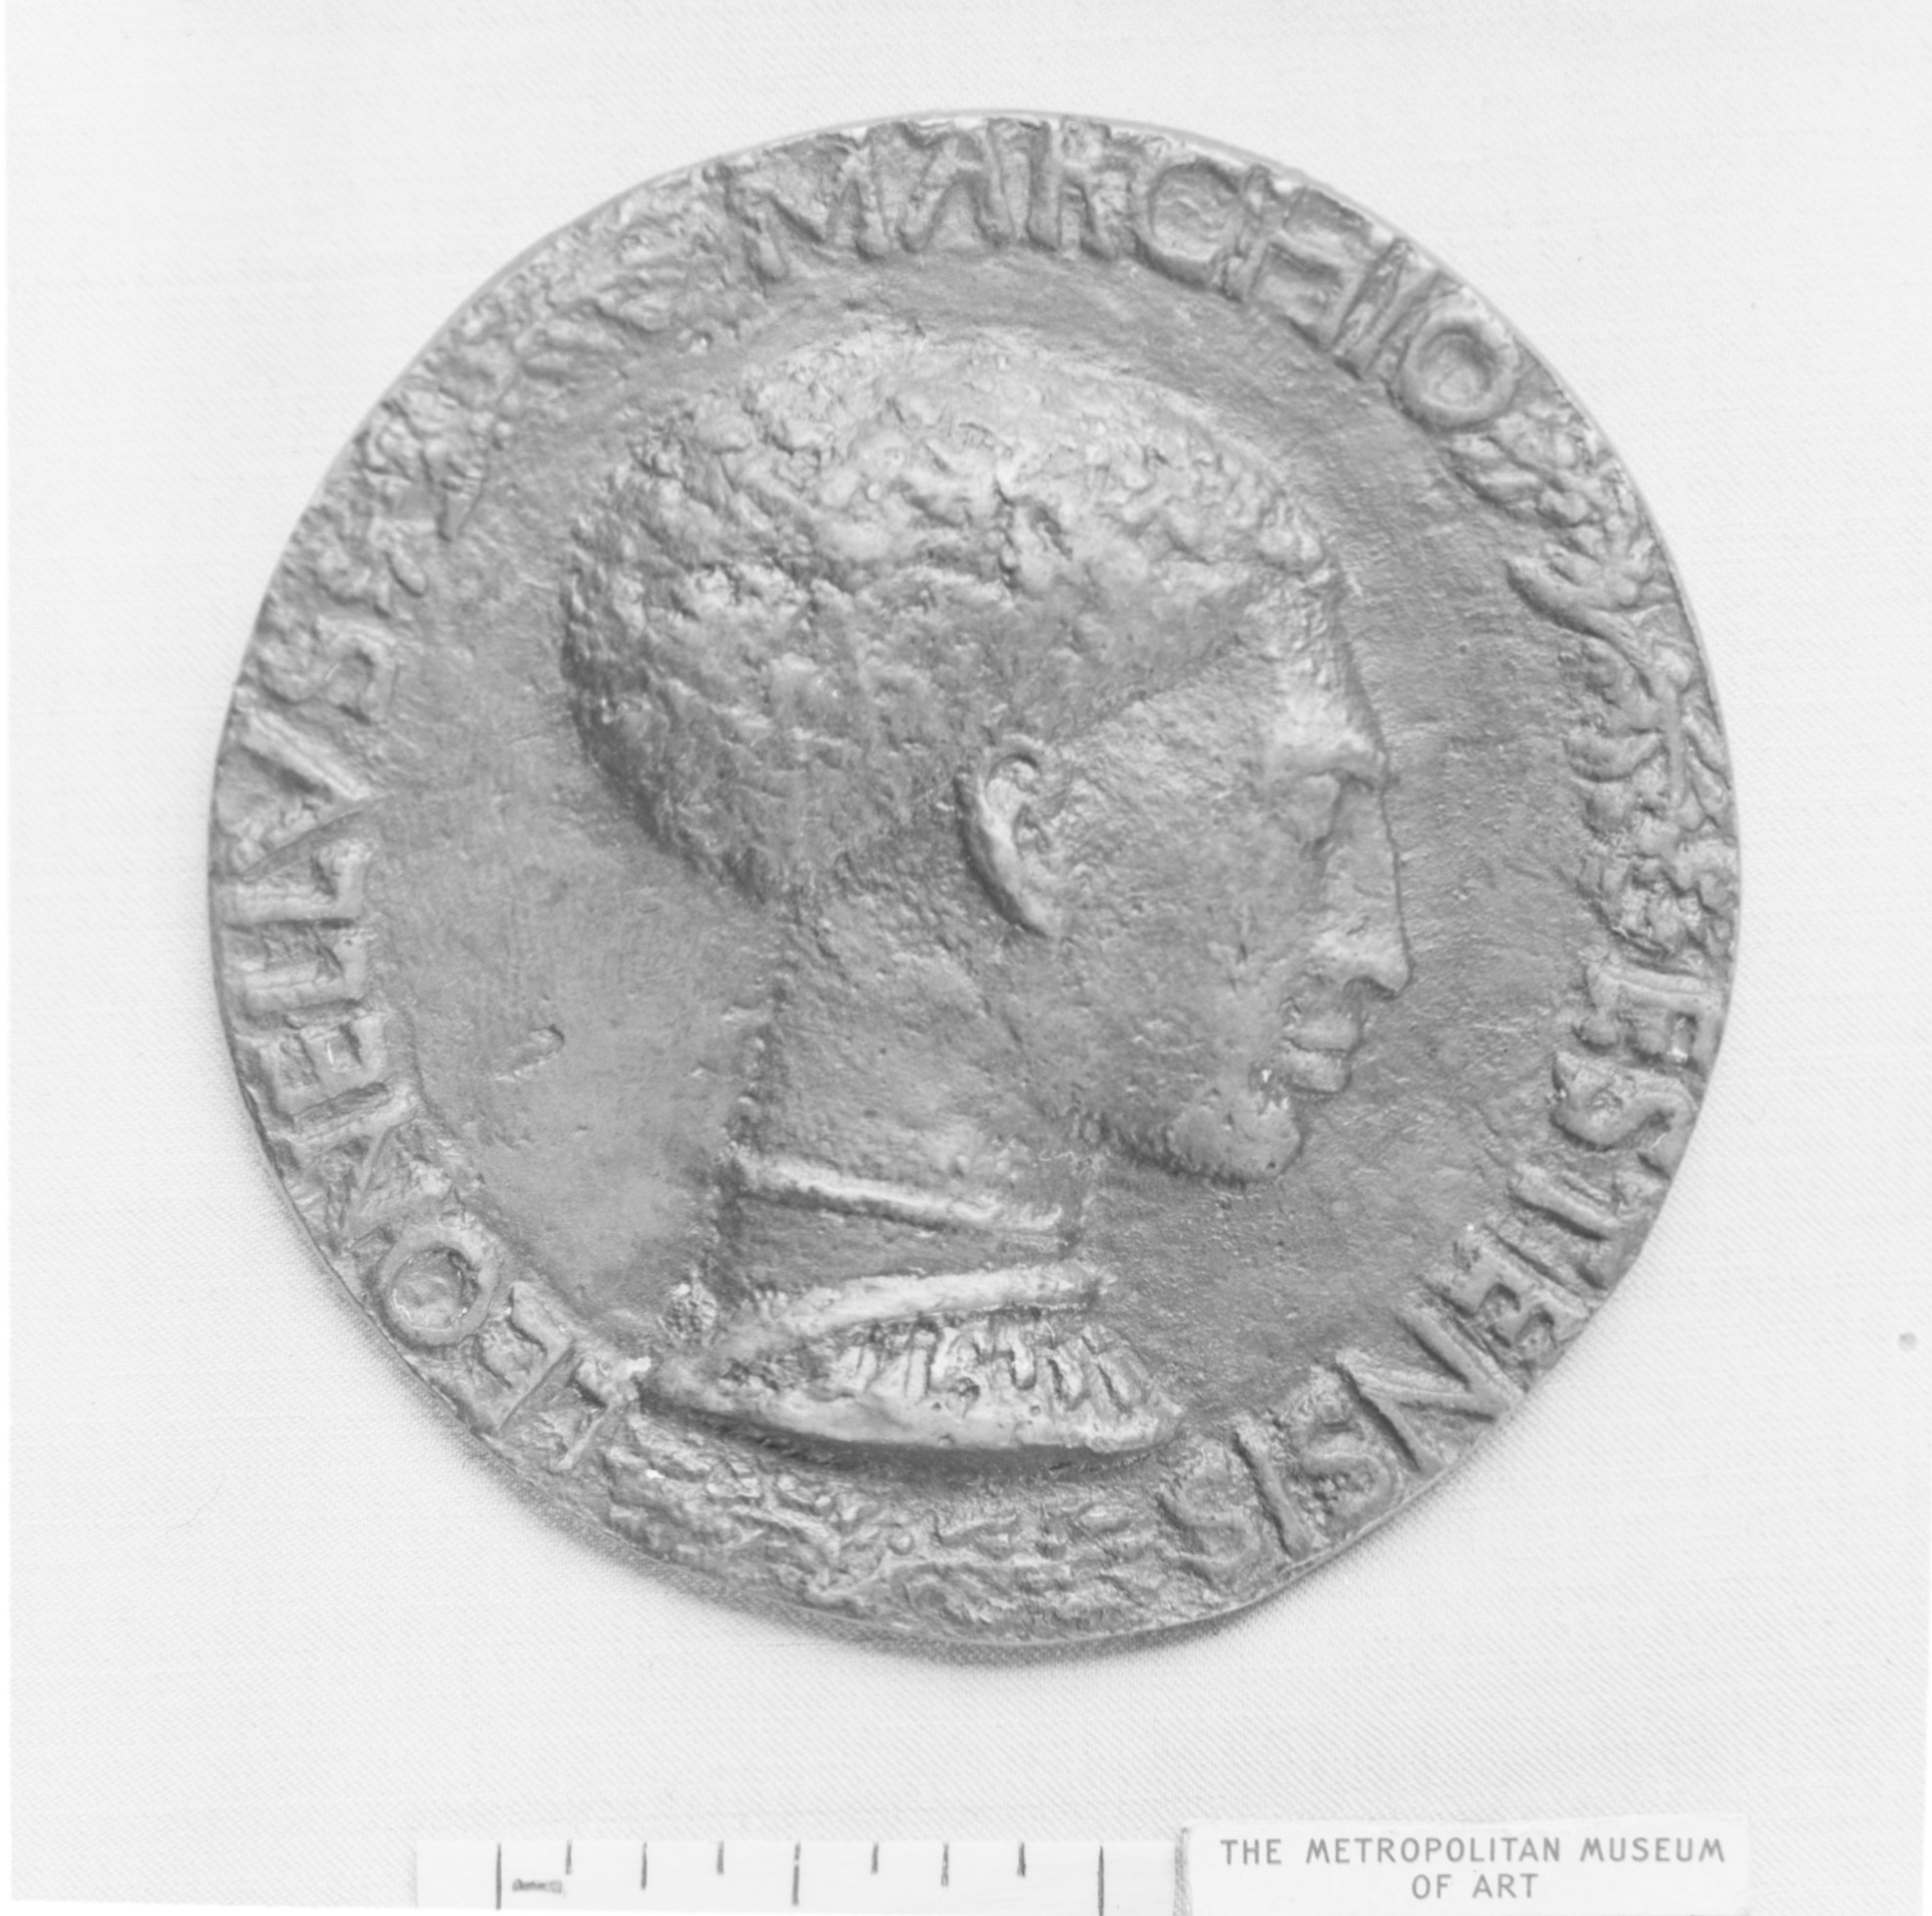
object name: medal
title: Leonello d'Este, Marquis of Ferrara (1407–1450)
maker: pisanello (antonio pisano)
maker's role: artist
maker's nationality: italian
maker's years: 1395-1455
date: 1441-1444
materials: bronze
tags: men,profiles